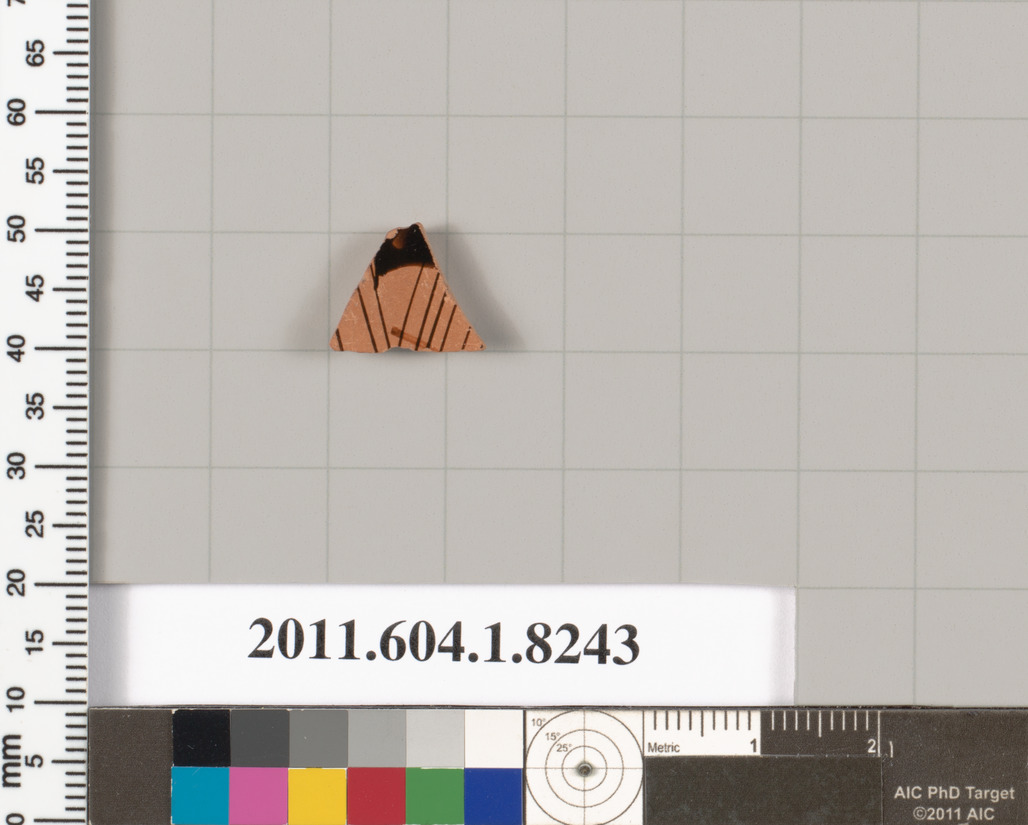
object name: kylix fragment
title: Terracotta fragment of a kylix (drinking cup)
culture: greek, attic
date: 520-510 BCE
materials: terracotta